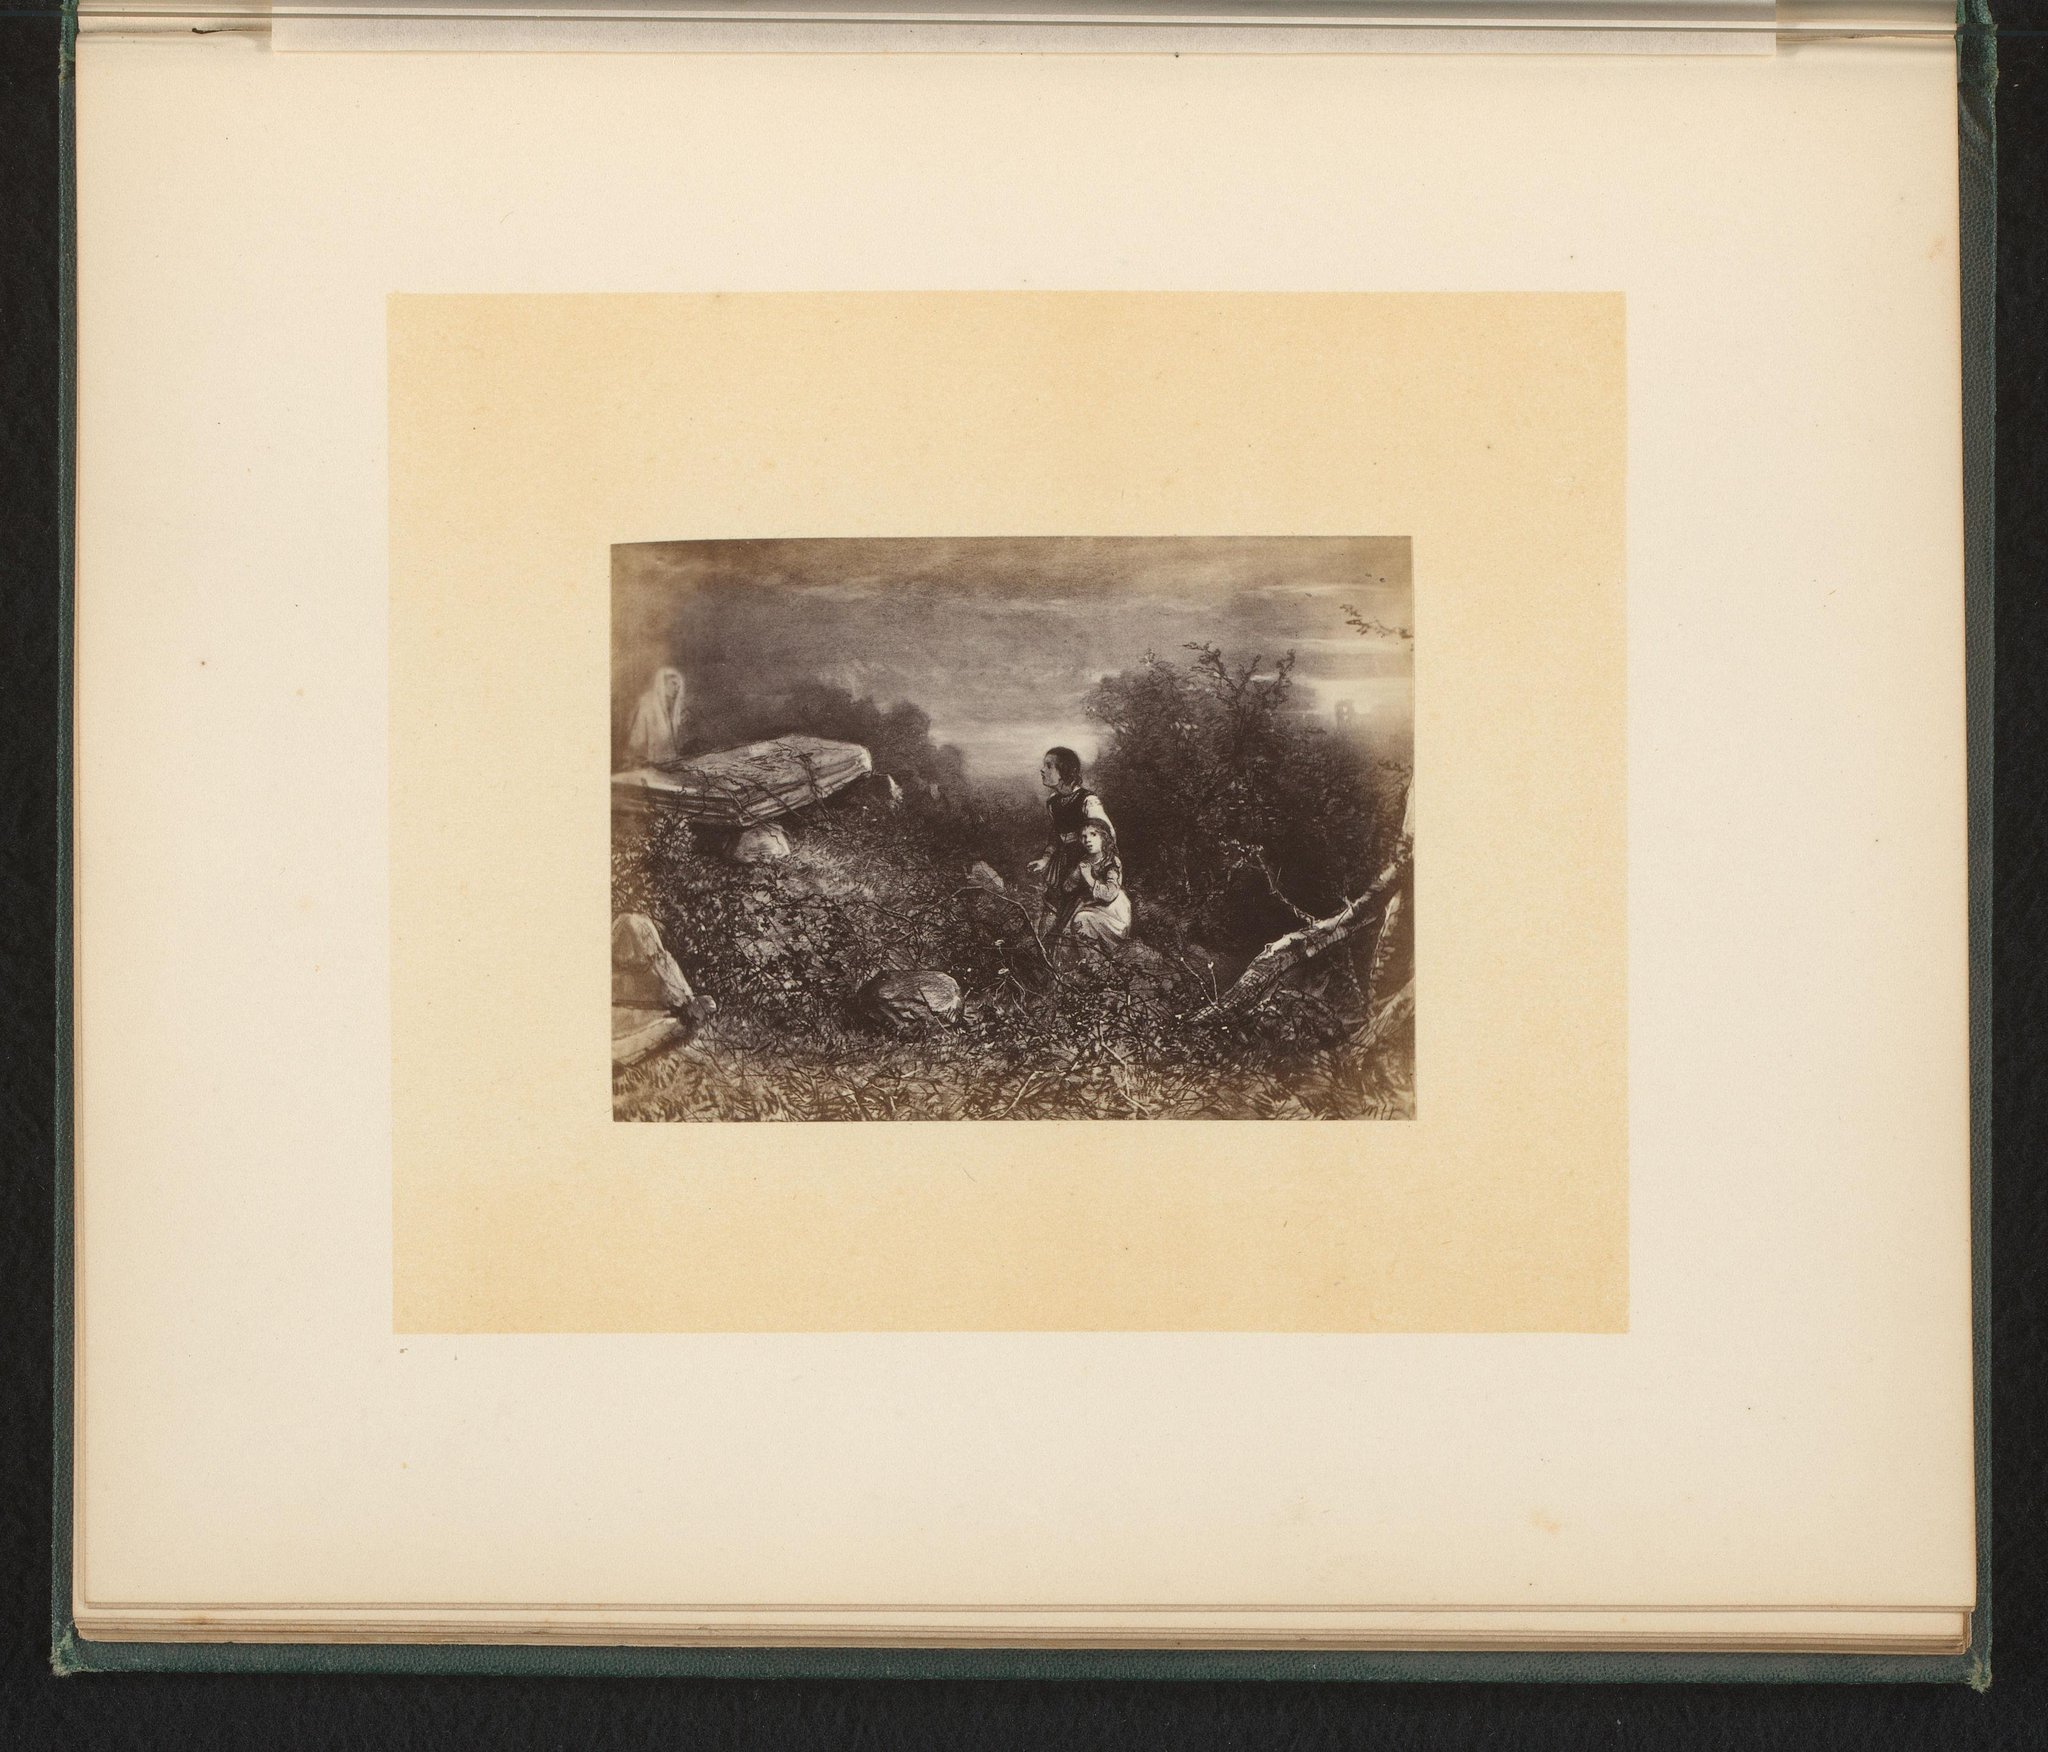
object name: reproduction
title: Fotoreproductie van een schilderij ter illustratie van Van Lenneps De Saxische Weezen door Mari ten Kate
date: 1870-1880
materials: paper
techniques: albumen print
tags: picture, painting